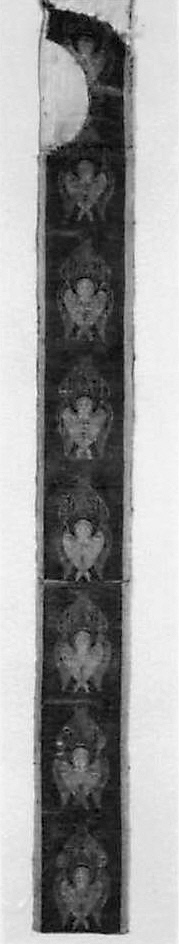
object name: panel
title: Panel wiht Seven Seraphim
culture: macedonian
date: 1601-1700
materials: metal thread, silk